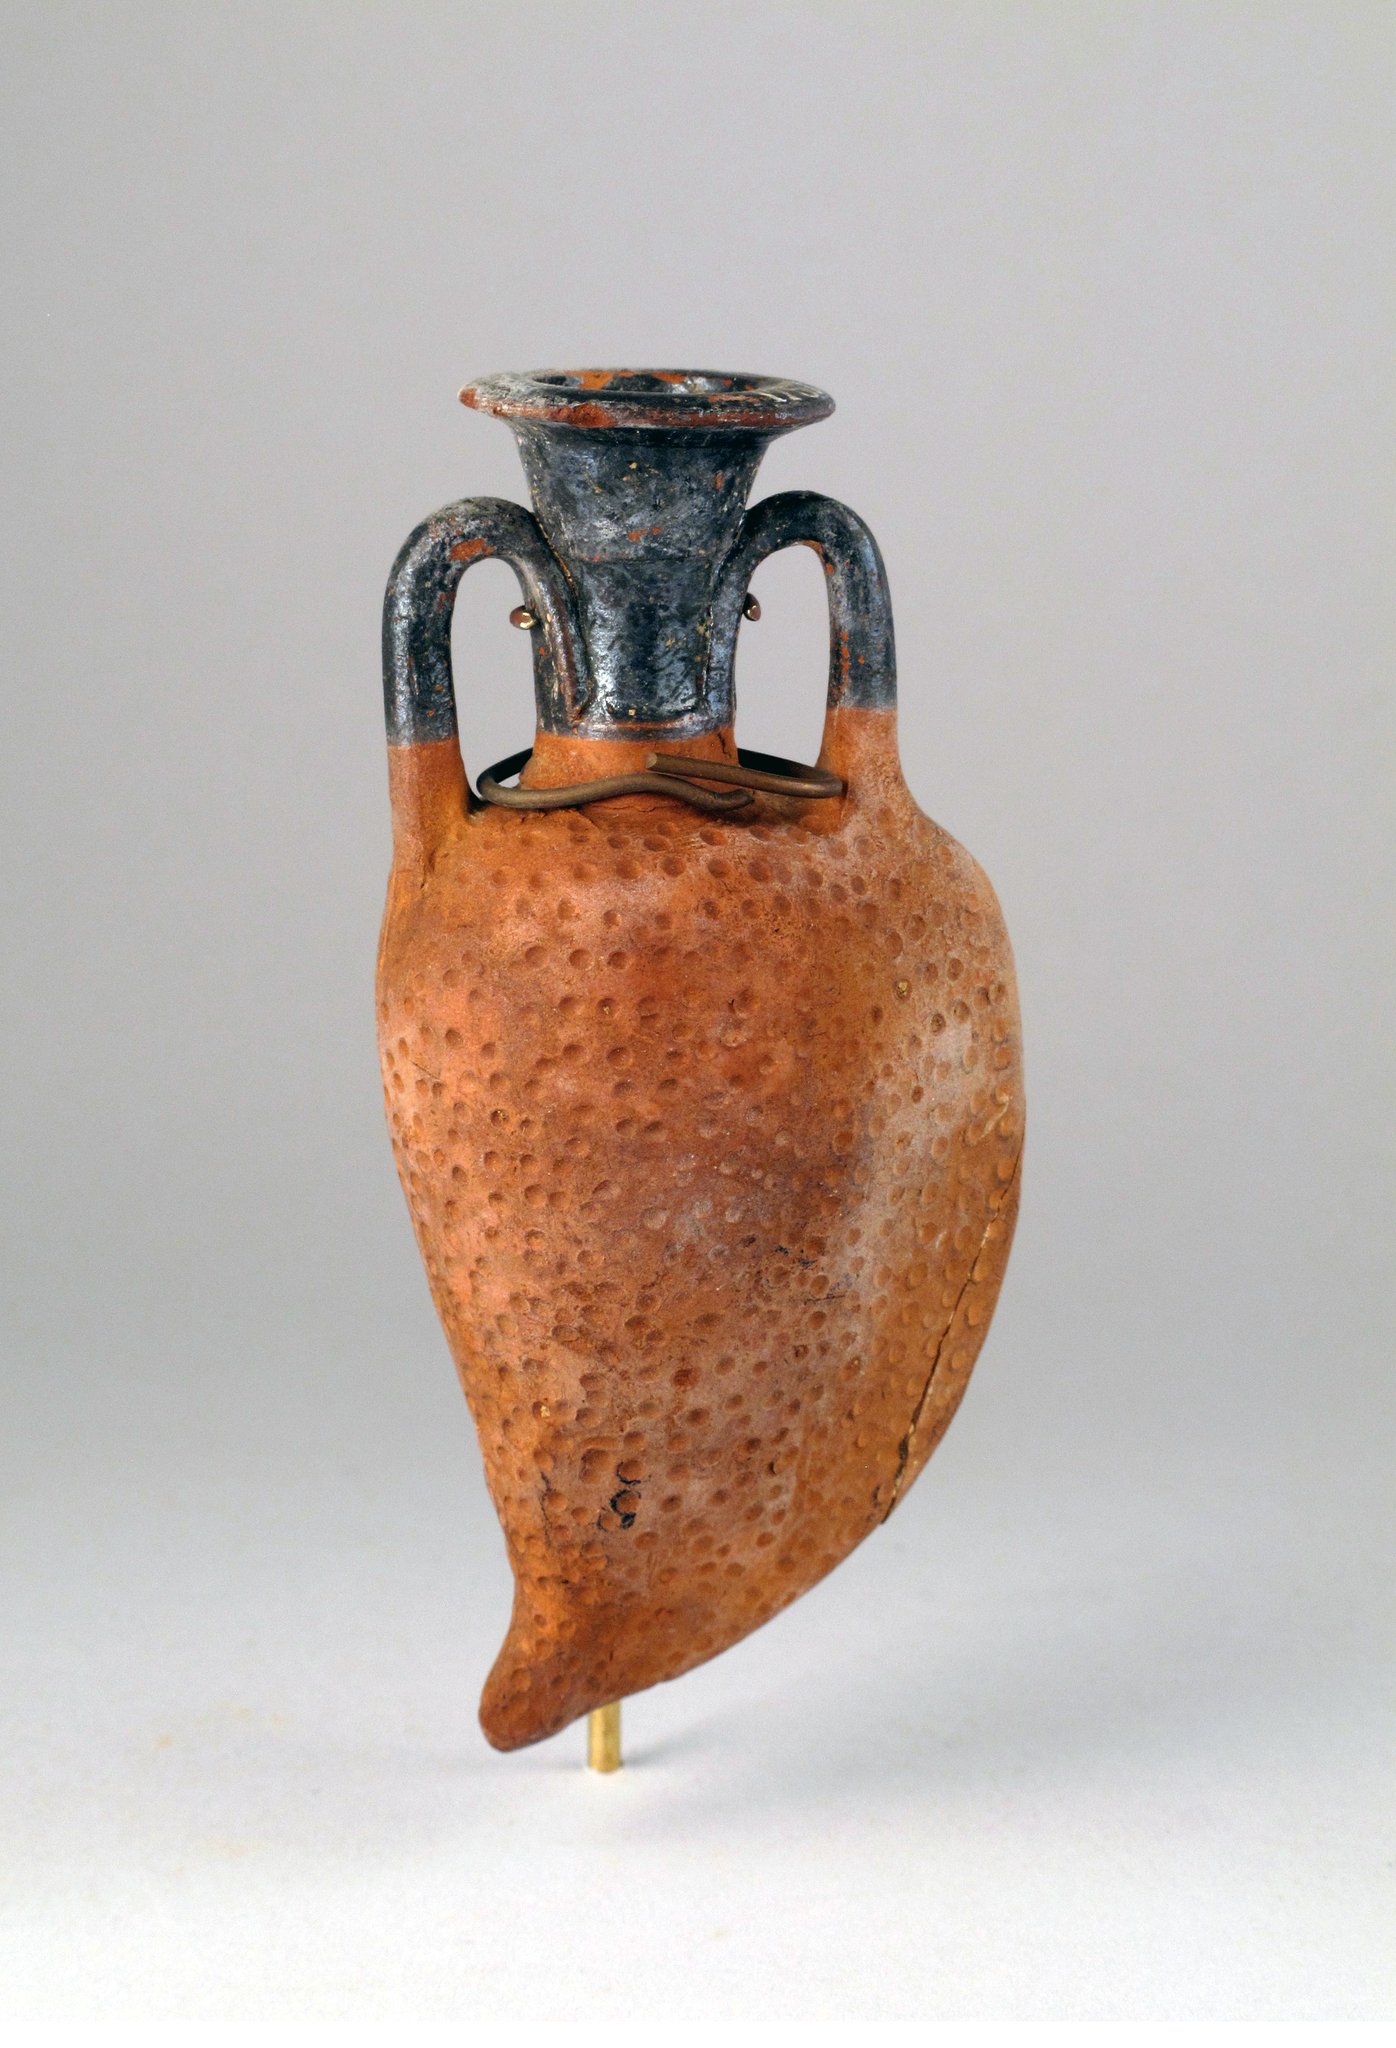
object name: amphoriskos in the form of an almond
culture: greek, attic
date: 400 BCE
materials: terracotta